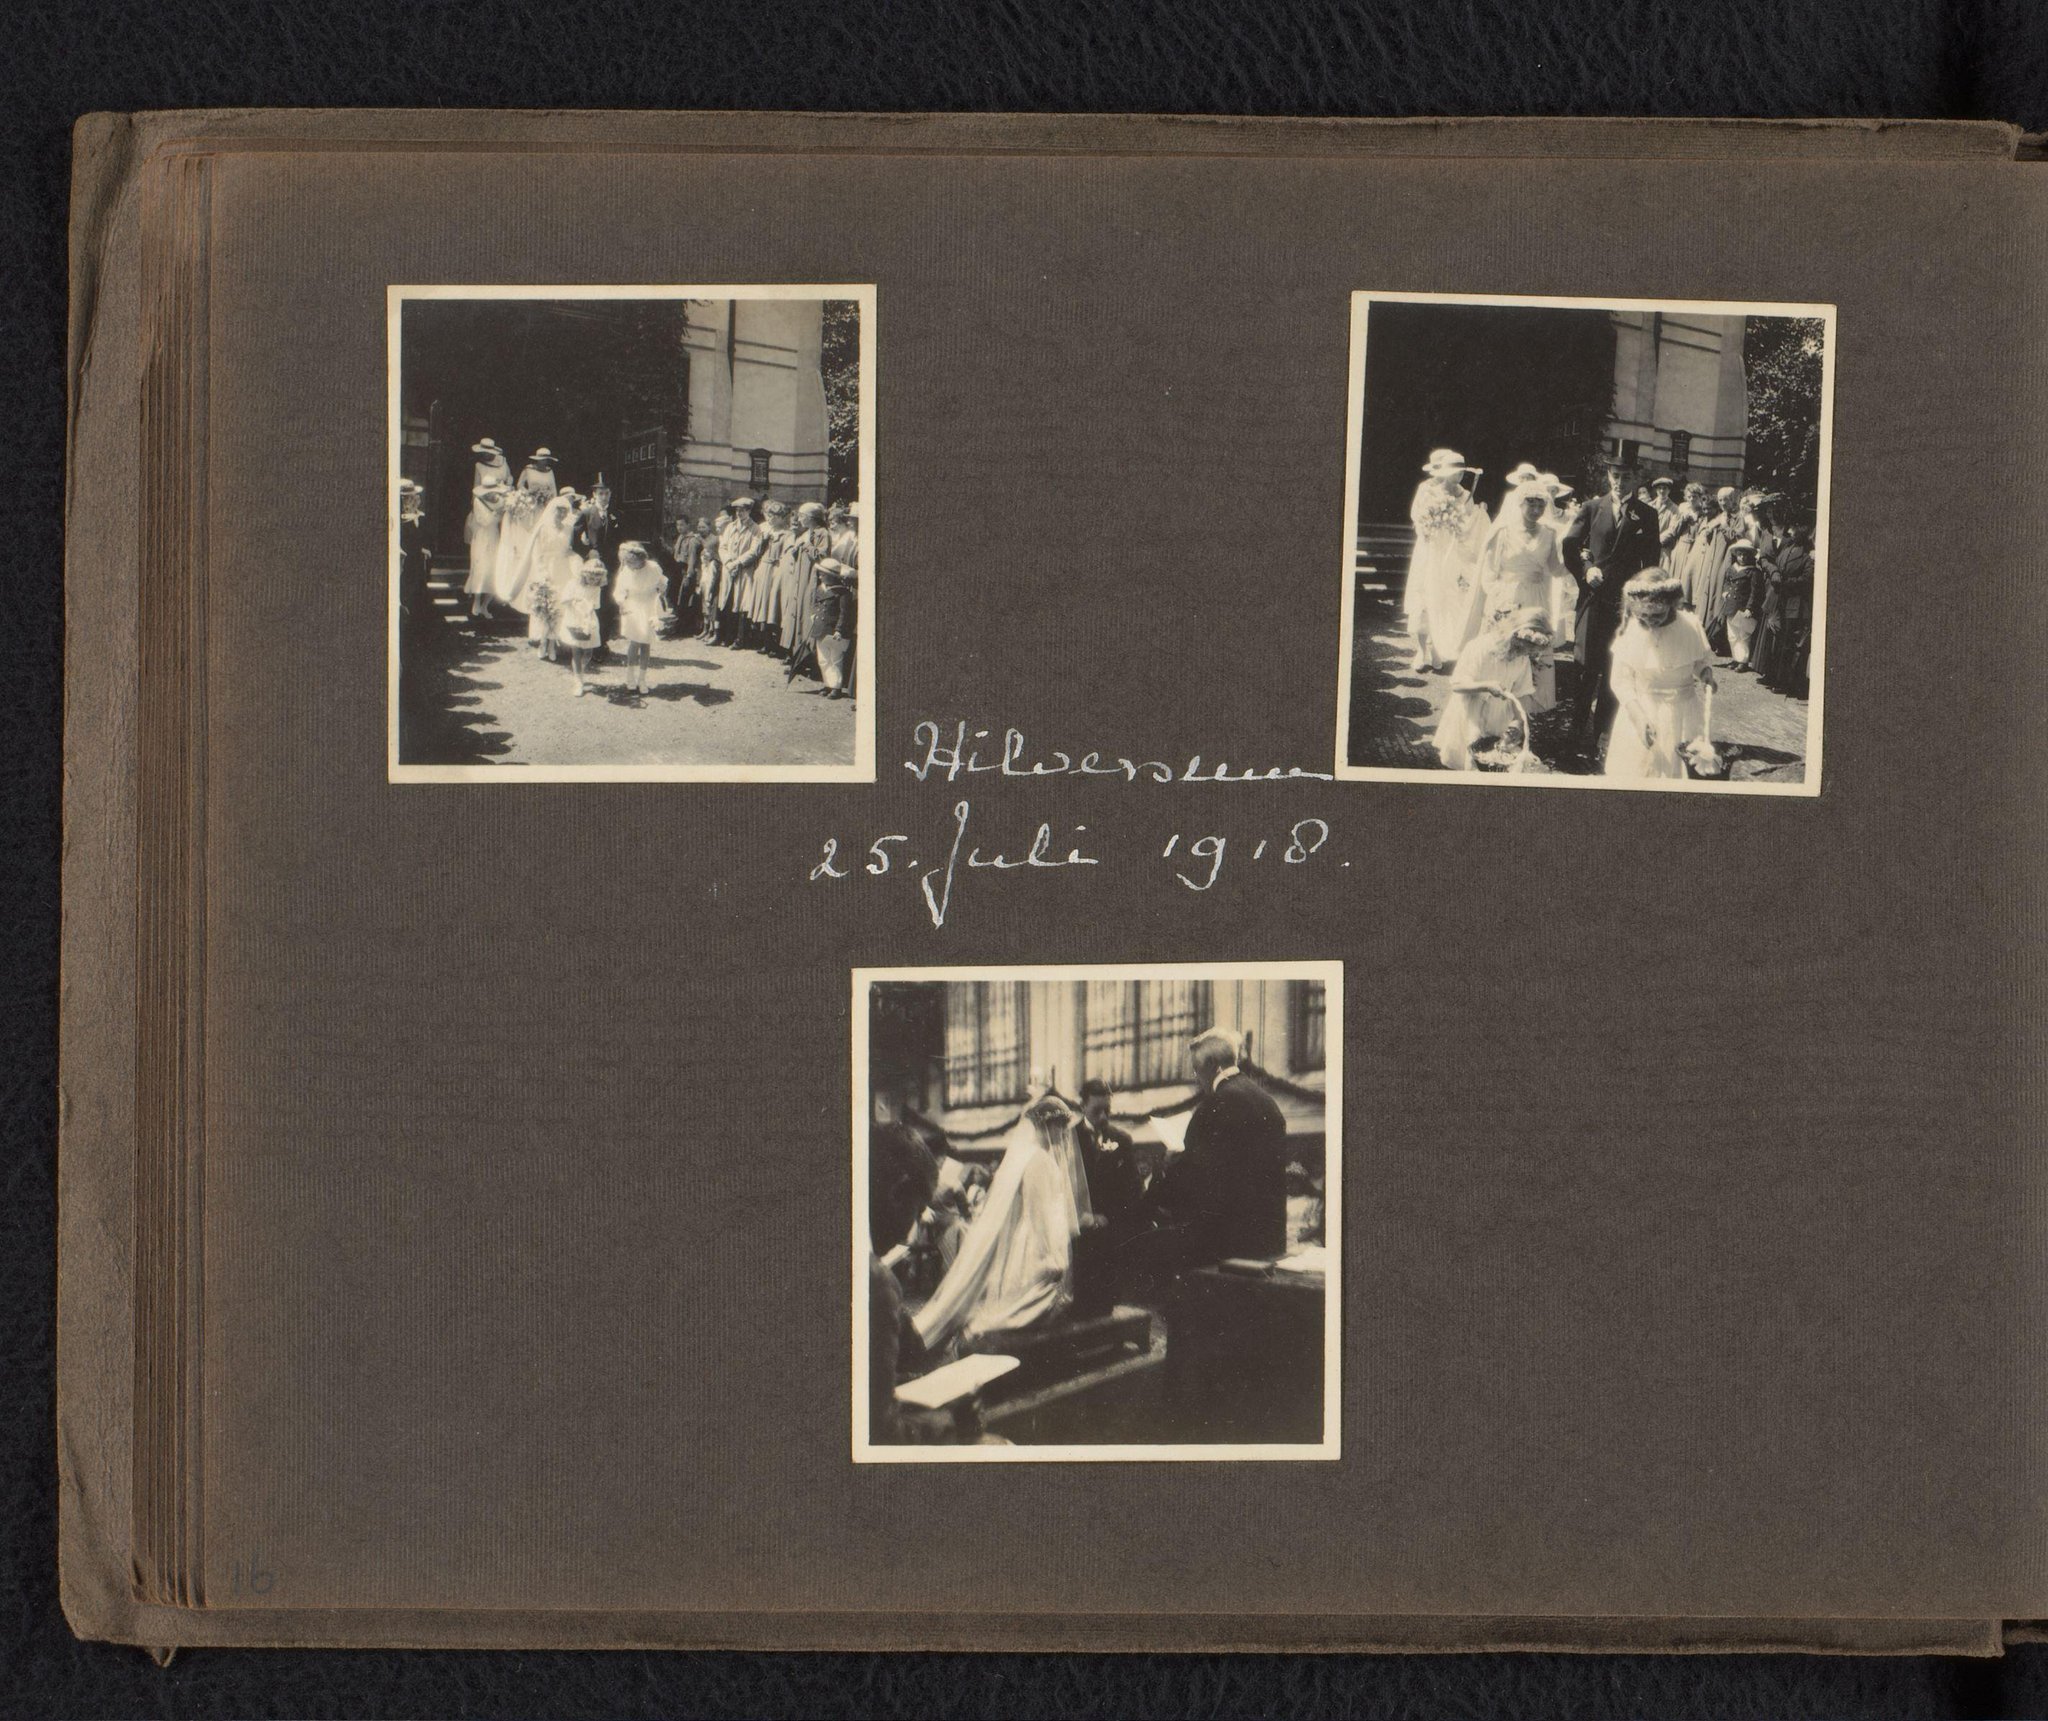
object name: photograph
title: Drie foto's van de huwelijksceremonie van Carolina Frederica Onnen en Frank Furnée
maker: Anonymous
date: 1918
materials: paper, cardboard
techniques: gelatin silver print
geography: hilversum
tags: the hague, historical persons - bb - woman, wedding feast, wedding meal, historical persons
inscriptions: caption: ‘Hilversum/ 25. Juli 1918.’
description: Deze foto's maken deel uit van een album.